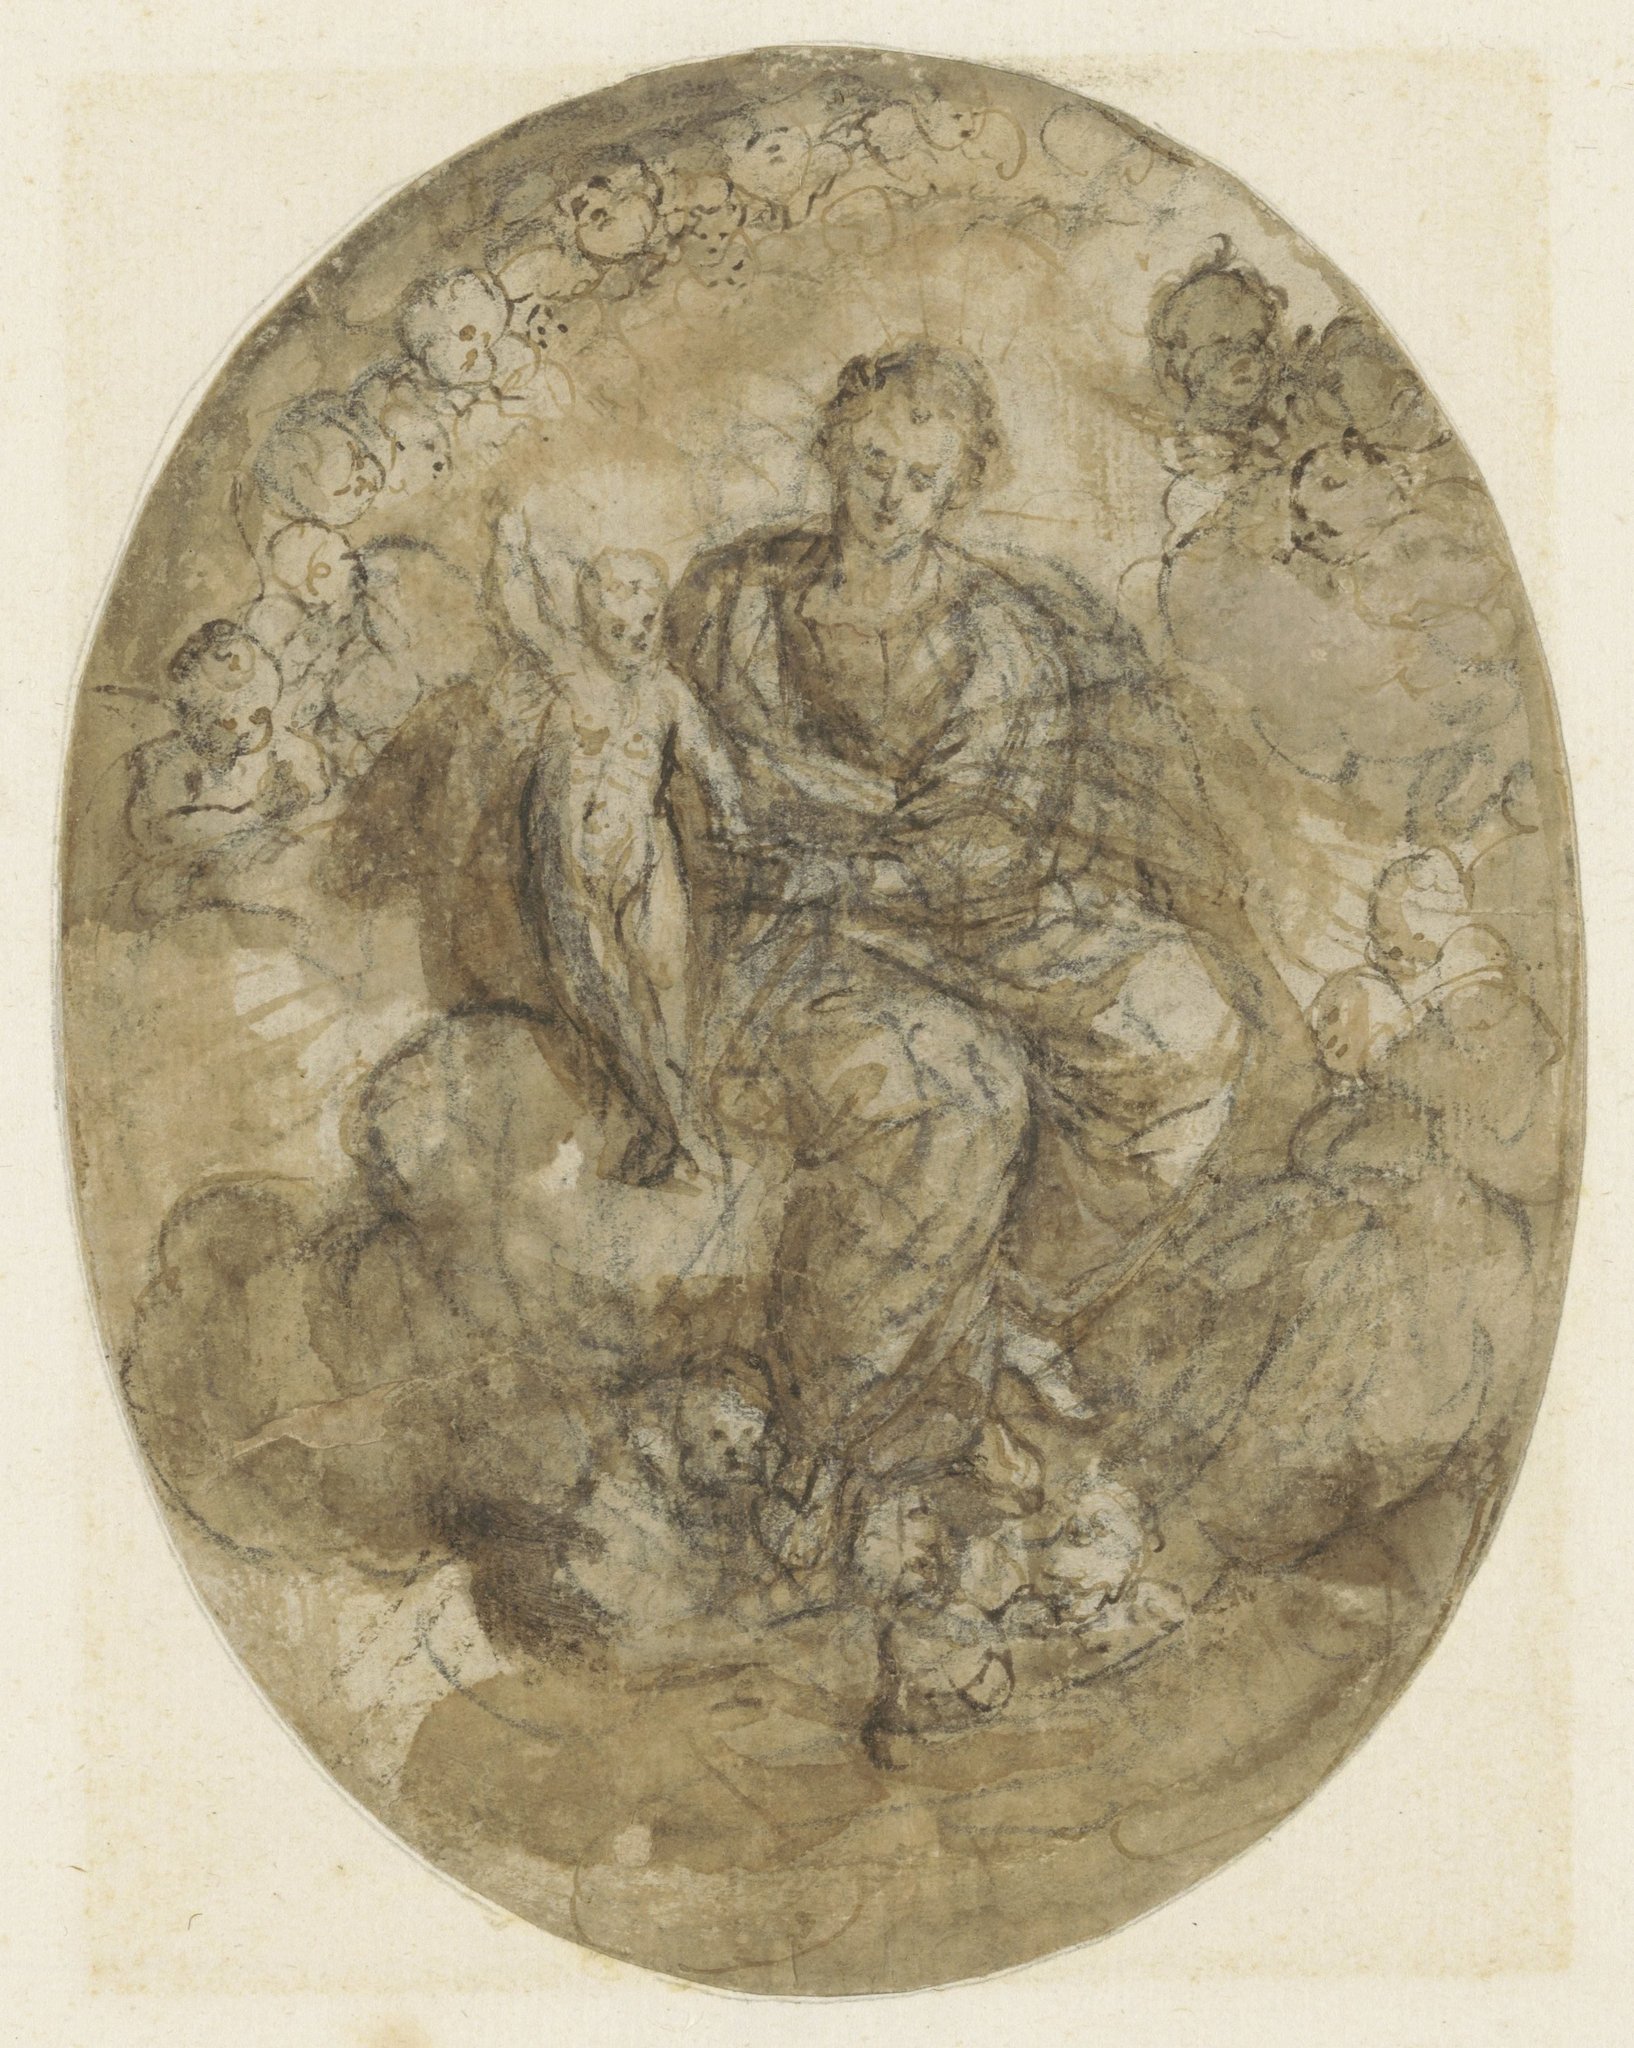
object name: drawing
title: Madonna met kind tussen engelen op de wolken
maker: jerónimo jacinto espinosa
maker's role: draughtsman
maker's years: 1600-1680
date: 1610-1680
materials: chalk, ink, paper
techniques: brush, pen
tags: madonna (i.e. mary with the christ-child) in the air, or on the clouds (+ angel(s))